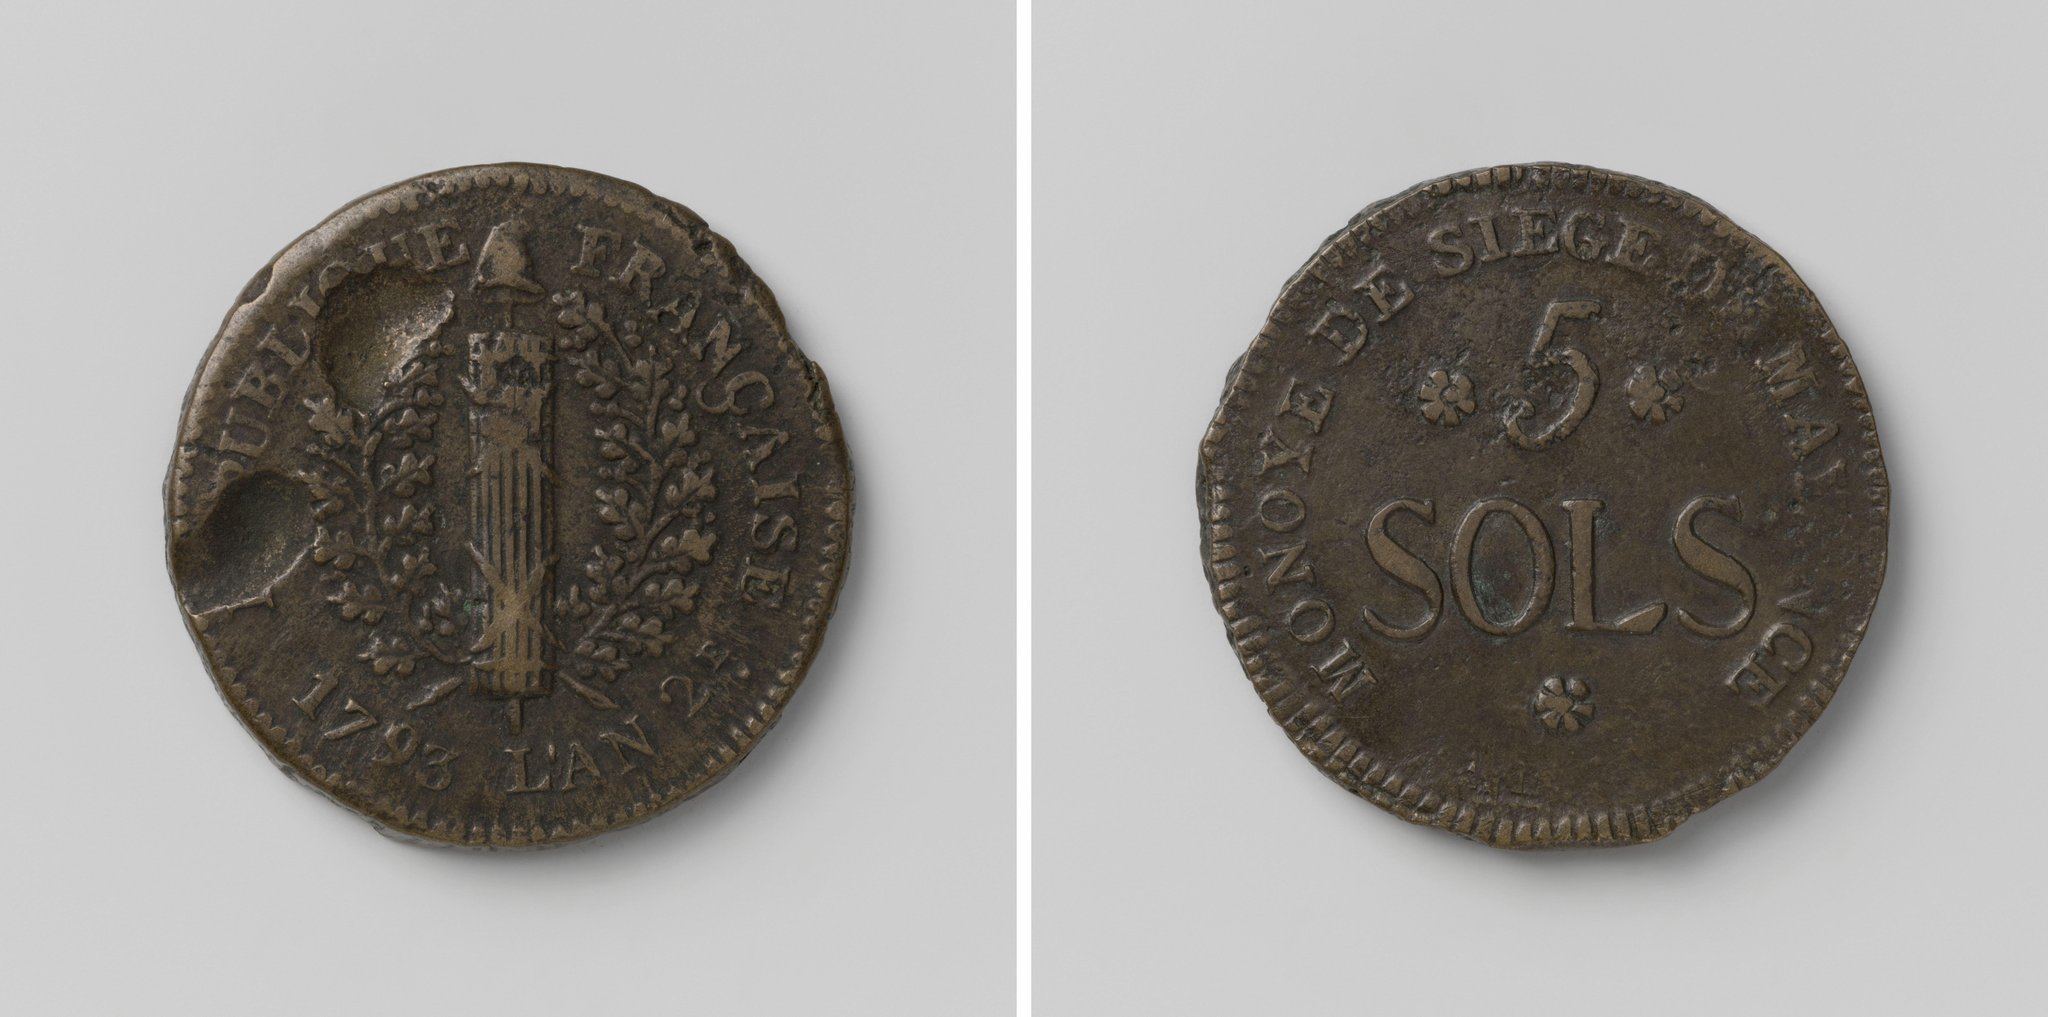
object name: vijf sol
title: Vijf stuivers, noodmunt van Mainz, geslagen tijdens het beleg door de geallieerden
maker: Anonymous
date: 1793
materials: copper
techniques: striking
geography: mainz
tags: mainz, beleg van mainz, franse revolutie, eerste coalitie-oorlog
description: Voorzijde: roedebundel met bijl, bekroond met vrijheidsmuts binnen eikekrans en omschrift. Keerzijde: waardeaanduiding binnen omschrift